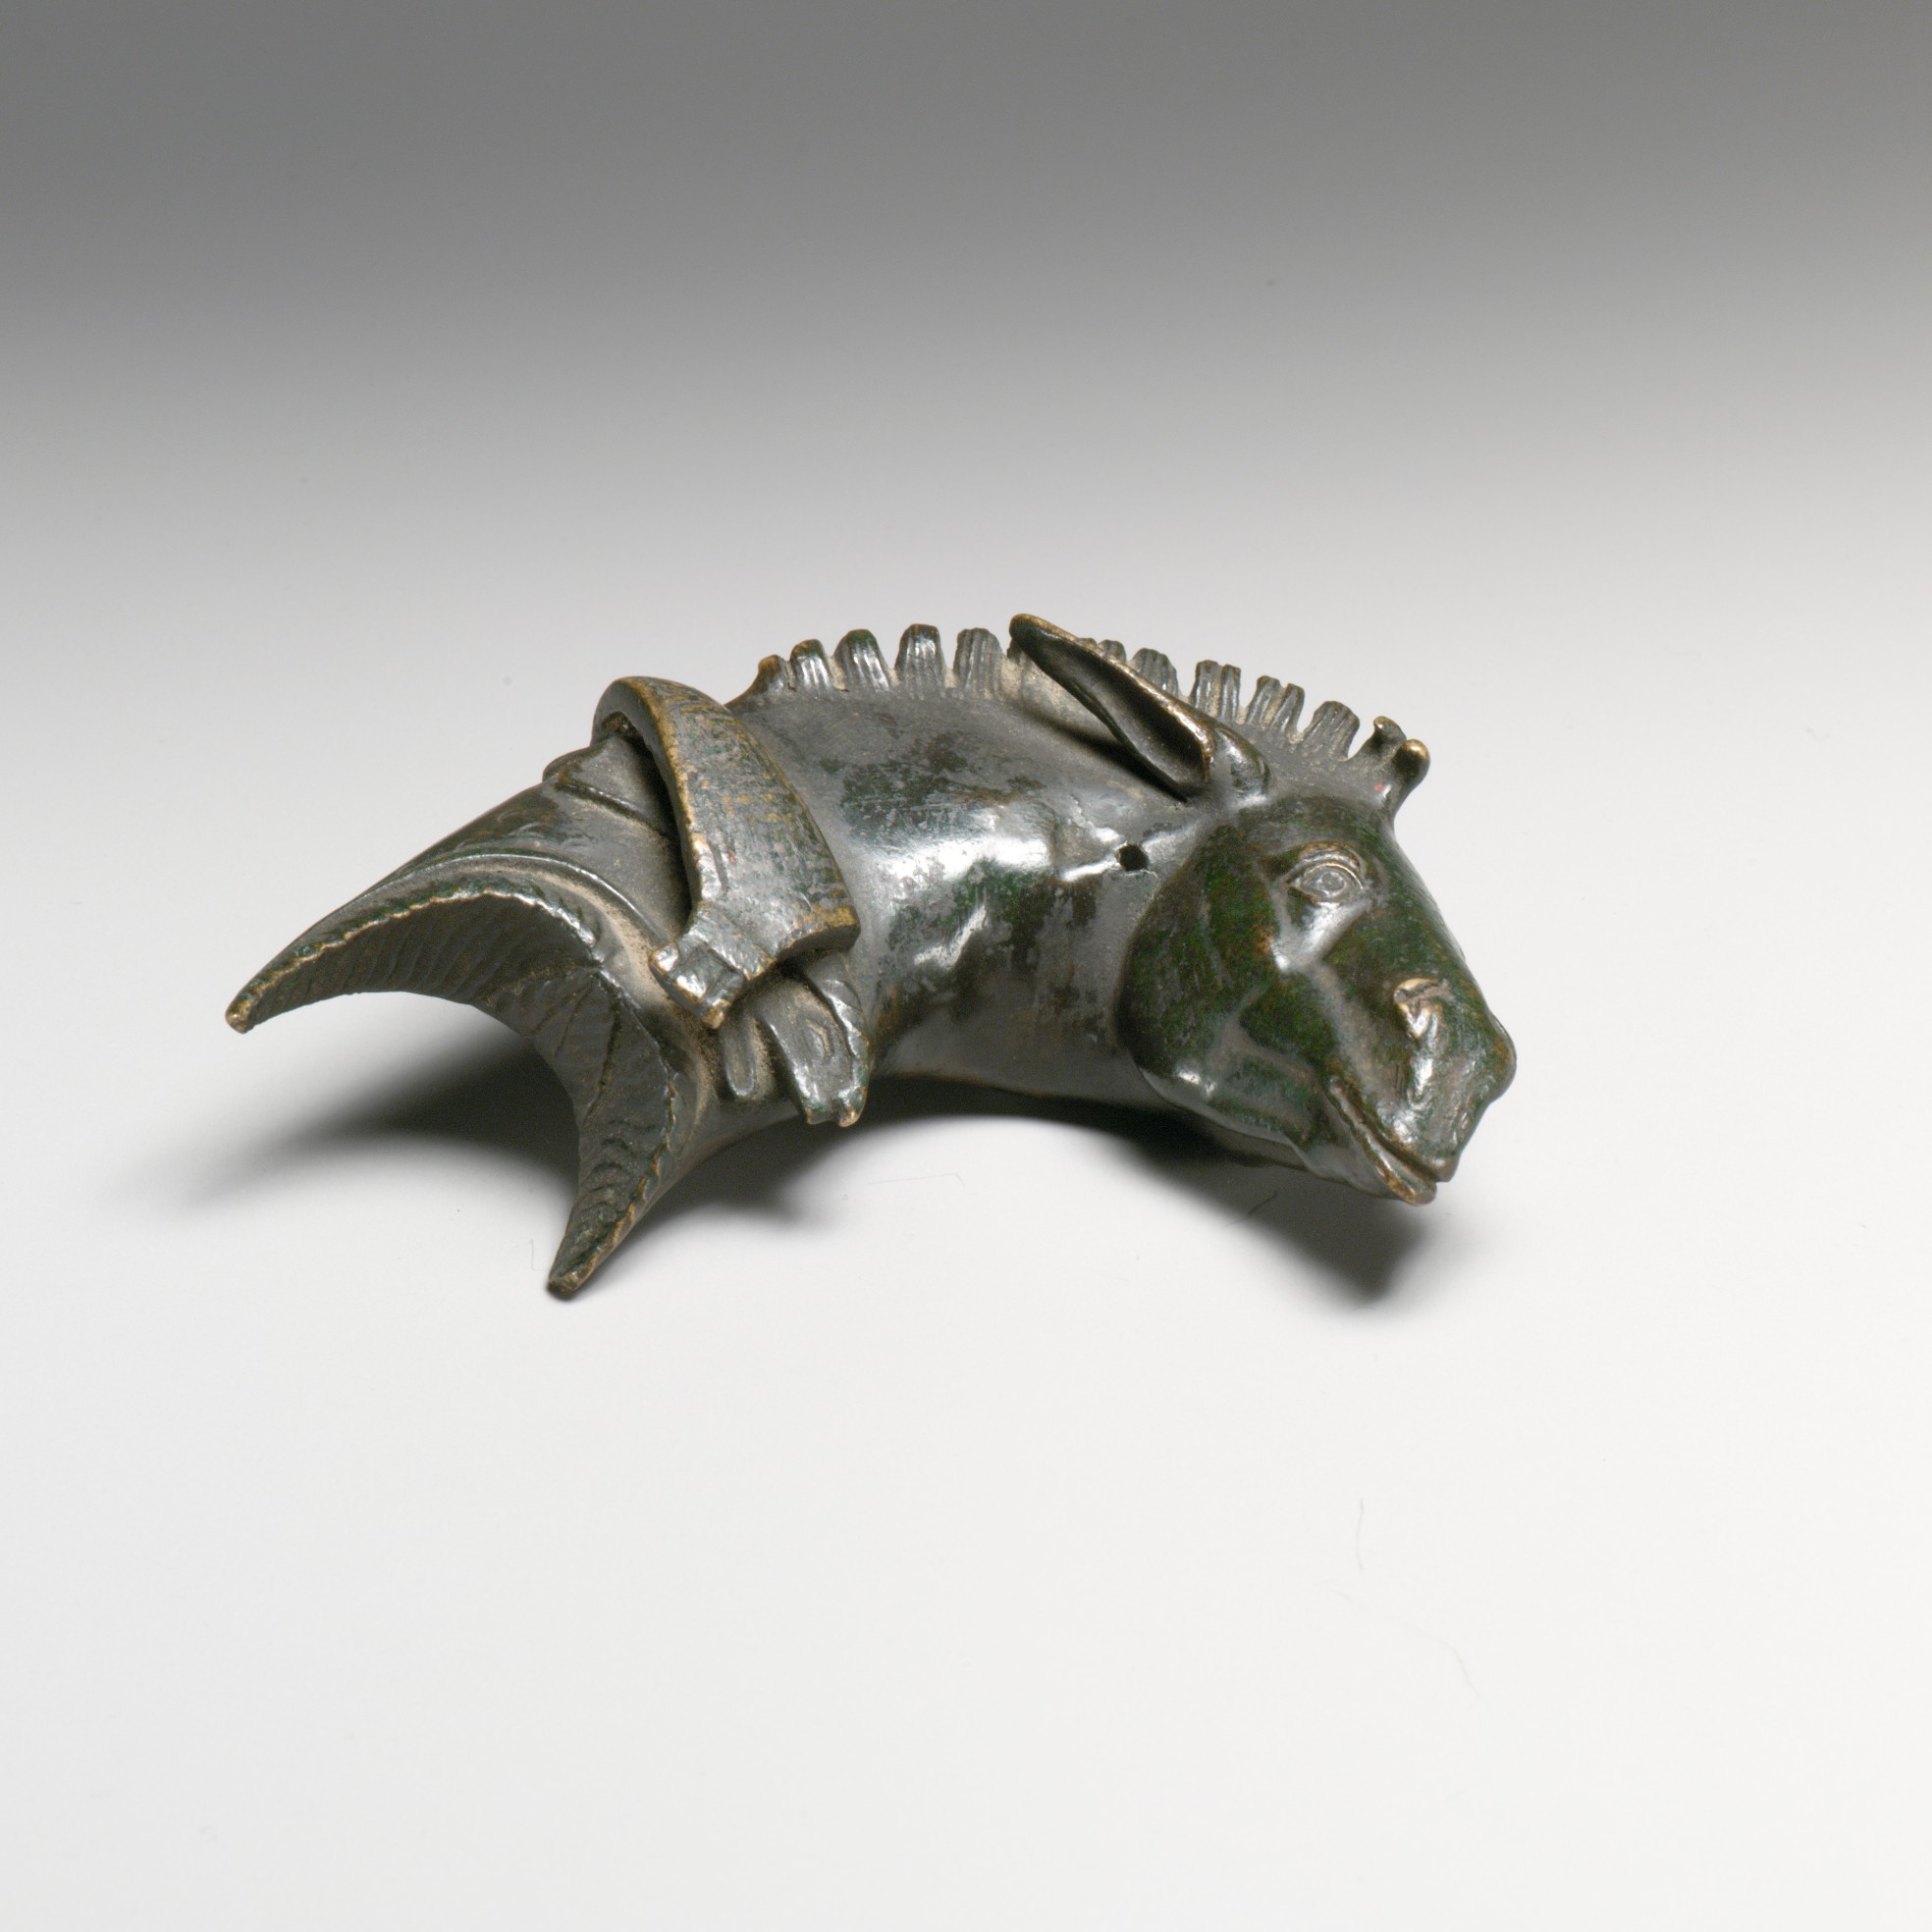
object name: furniture attachment, head of a mule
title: Bronze furniture attachment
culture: roman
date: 1-100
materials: bronze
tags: animals